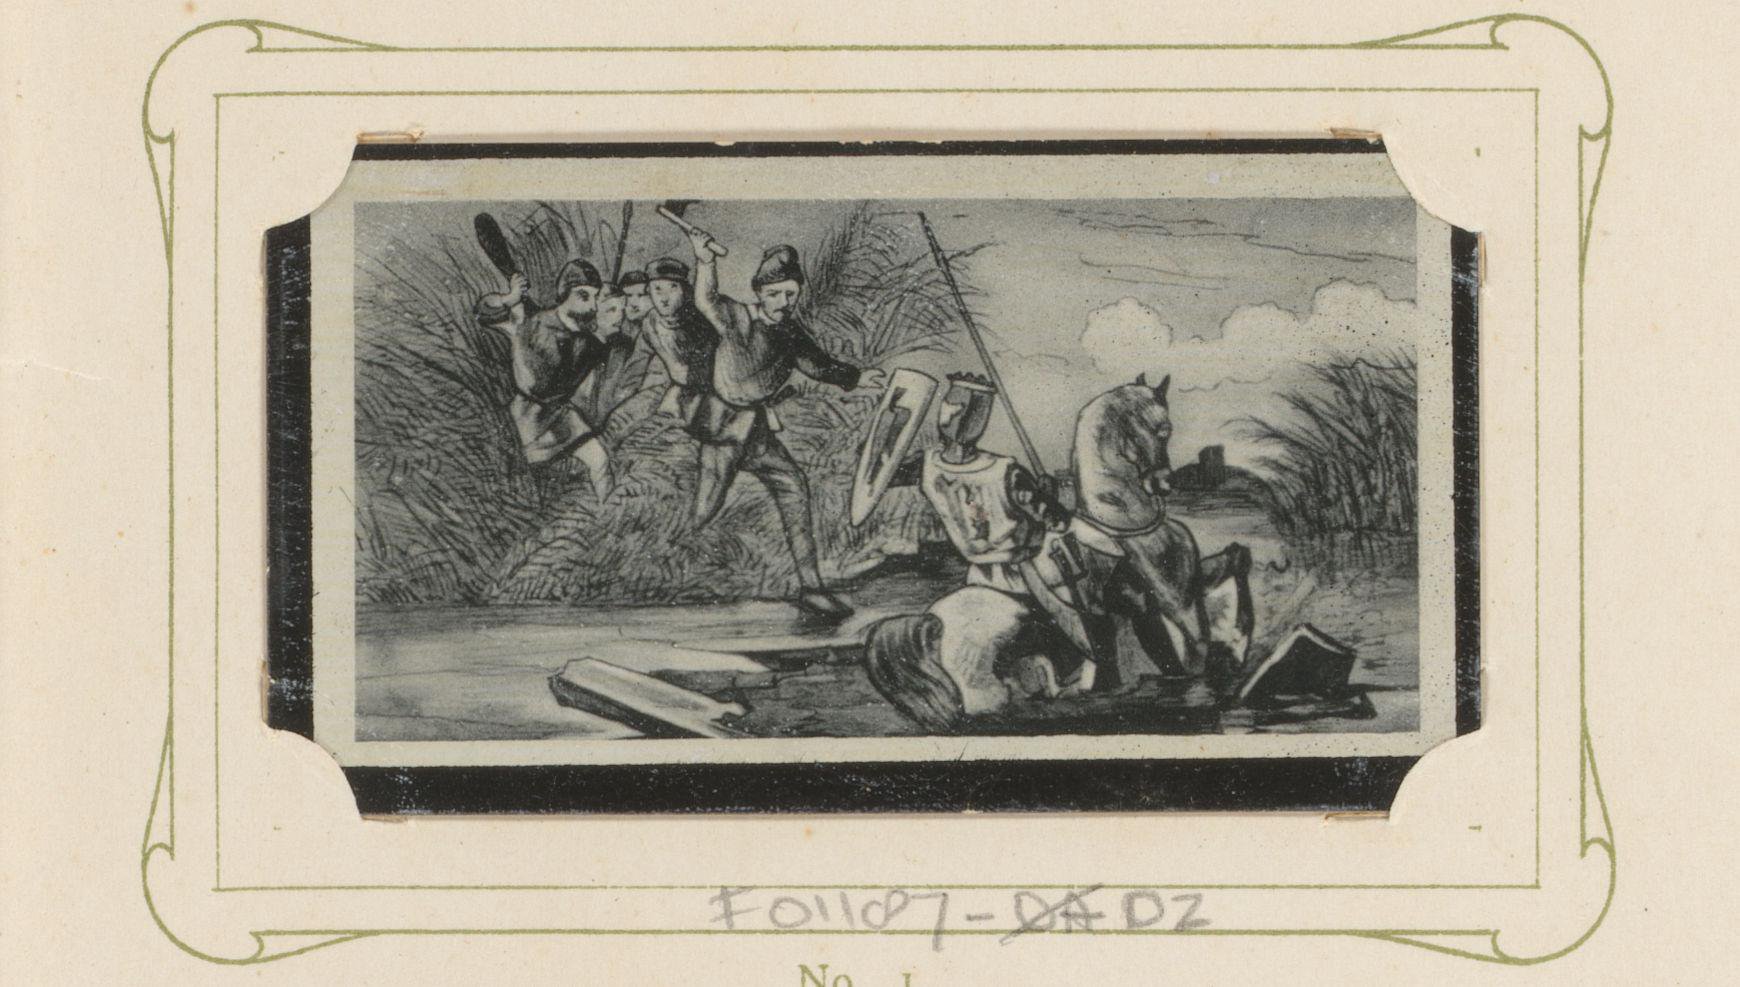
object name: photomechanical print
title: Reproductie van een tekening van de moord op graaf Willem II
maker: Anonymous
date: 1905-1906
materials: paper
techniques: photograph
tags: earl, winter landscape; landscape symbolizing winter (the four seasons of the year), murder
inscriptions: inscription: ‘No. 1./ Graaf Willem II in het ijs vermoord.’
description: Deze prent maakt deel uit van een album.